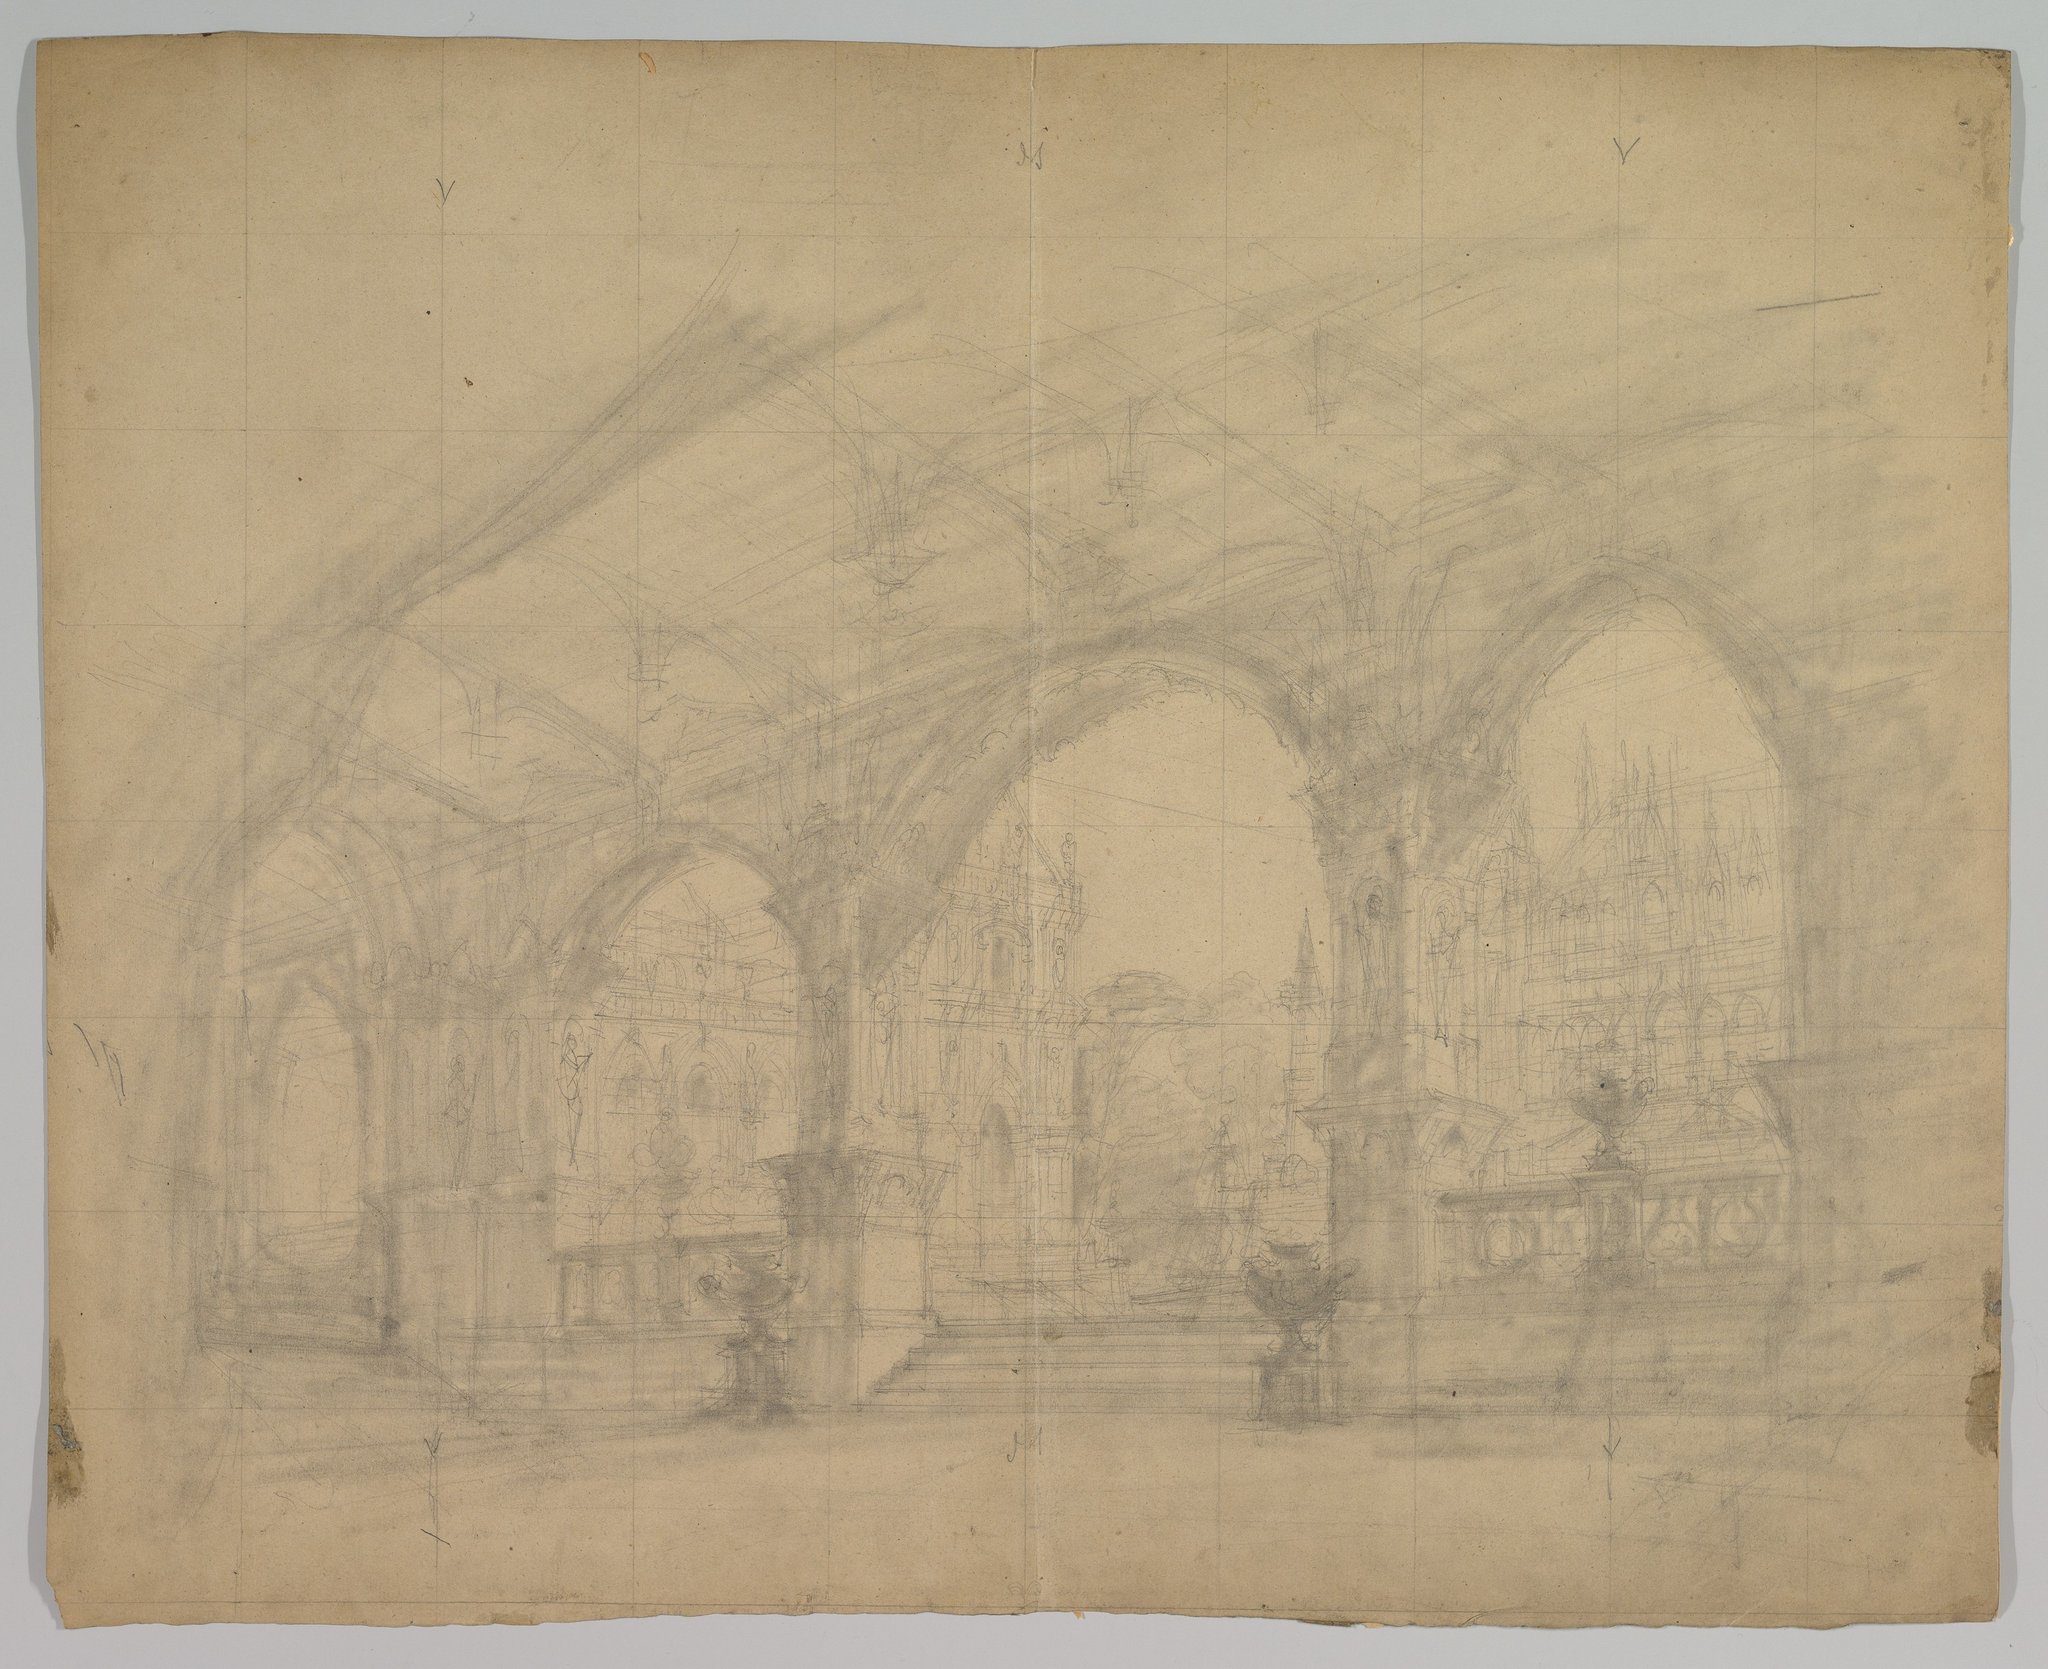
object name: drawing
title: Design for a Stage Set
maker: eugène cicéri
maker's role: artist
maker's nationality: french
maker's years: 1813-1890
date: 1830-1890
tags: stage design